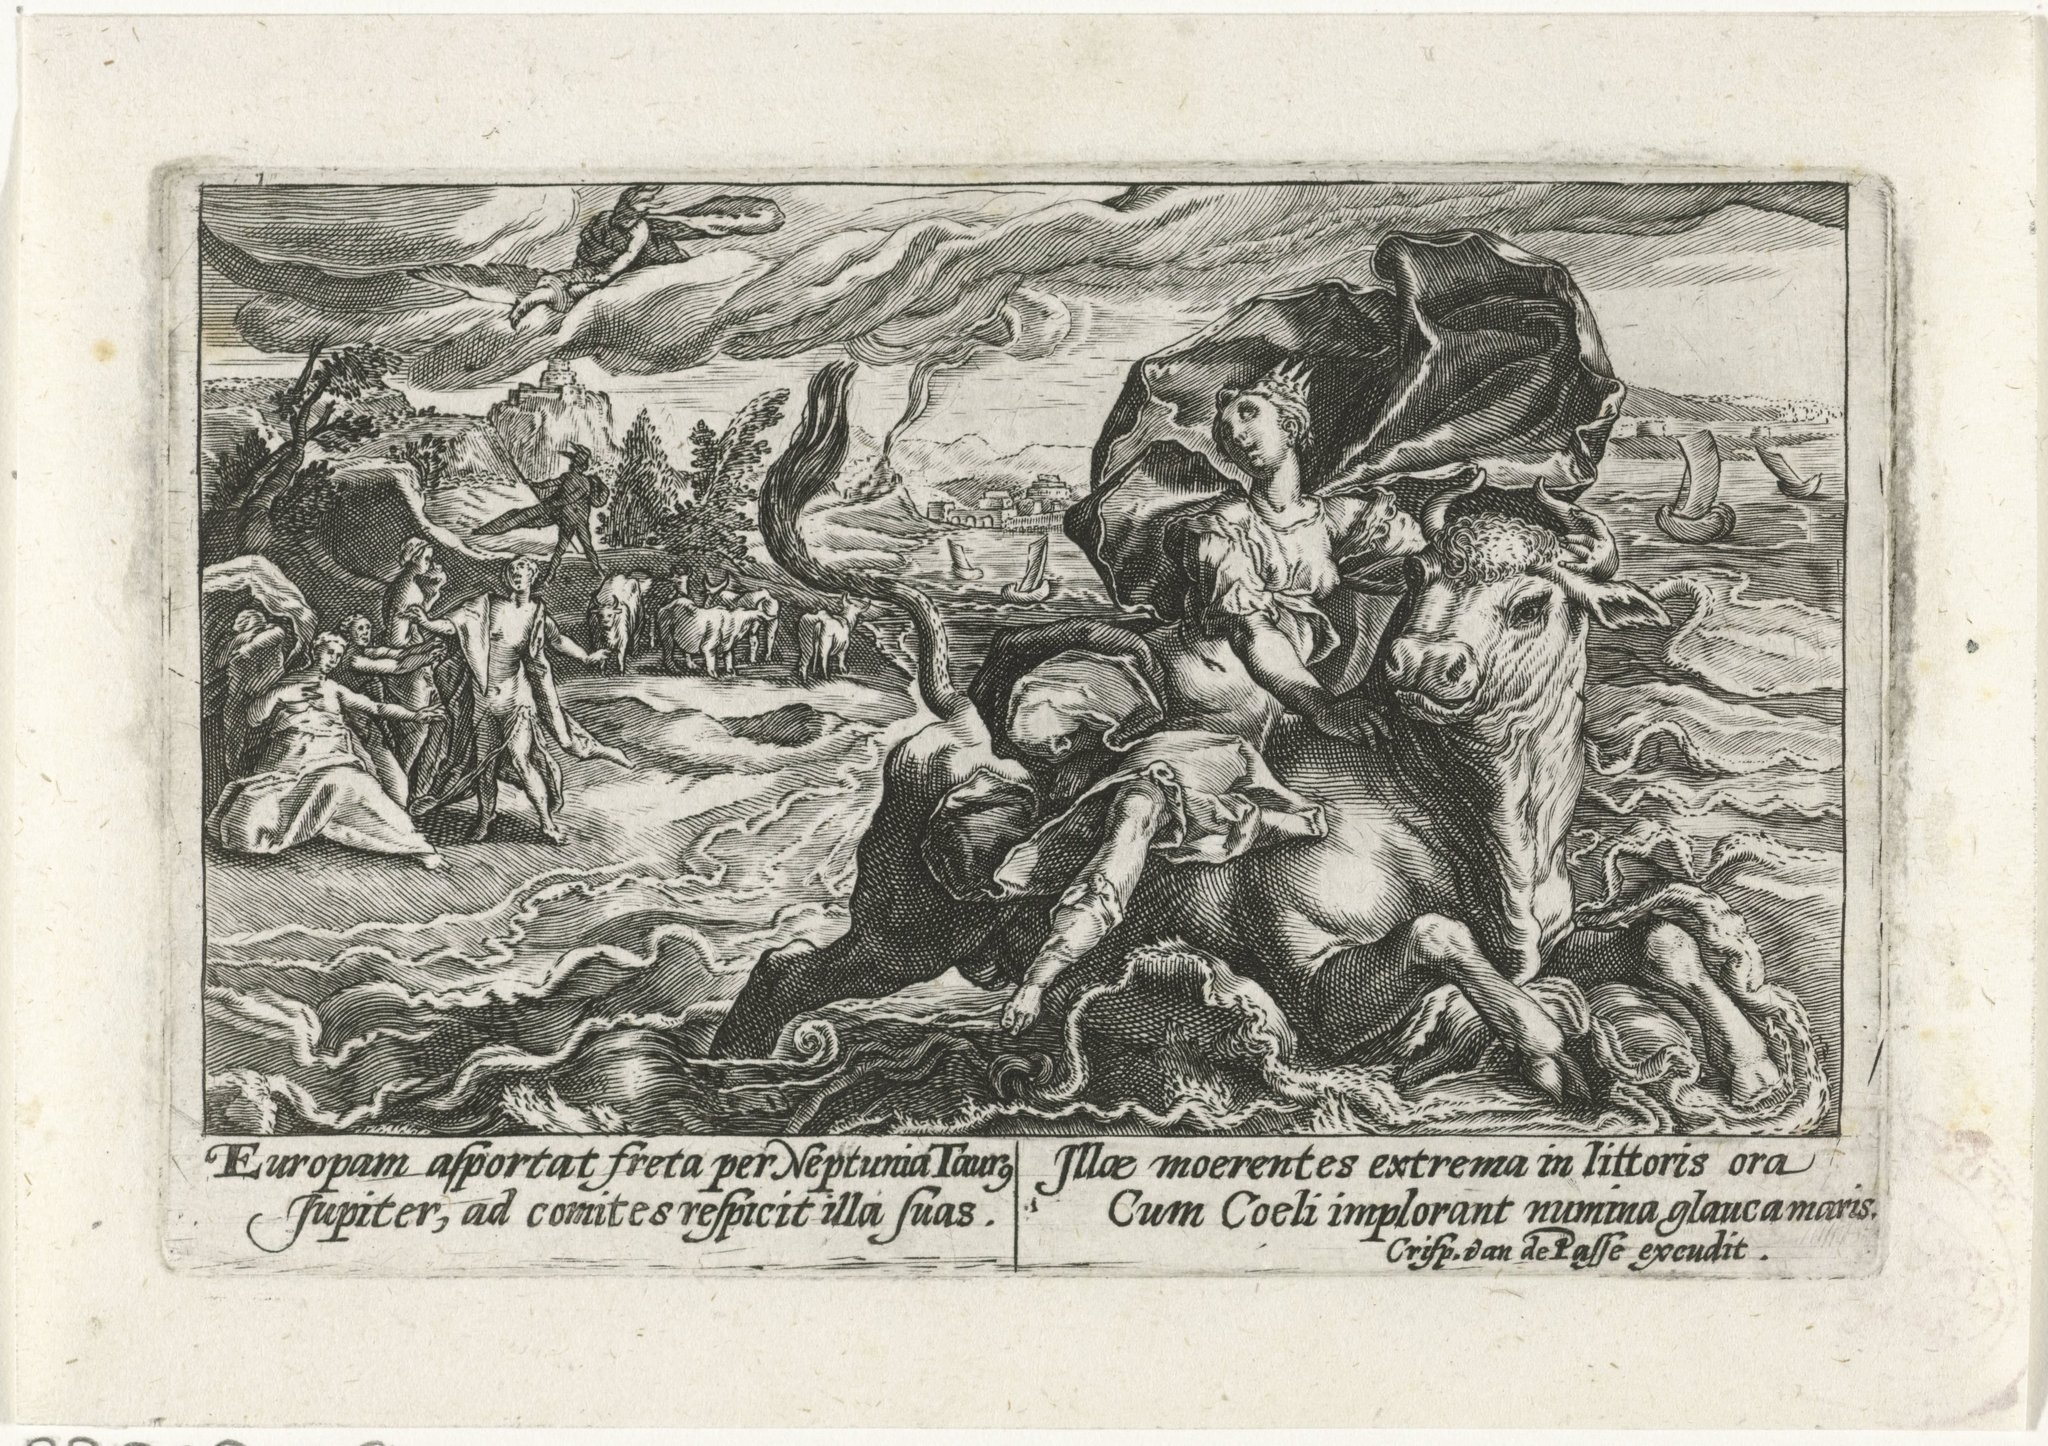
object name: print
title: Roof van Europa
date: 1602-1607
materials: paper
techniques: engraving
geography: cologne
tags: jupiter, usually in the shape of a white bull, abducts europa and carries her across the water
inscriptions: collector's mark: Lugt 240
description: Jupiter, in de gedaante van een witte stier, voert Europa weg door de zee. Haar dienstmaagden blijven wanhopig achter op het strand. In de marge een vierregelig onderschrift, in twee kolommen, in het Latijn.